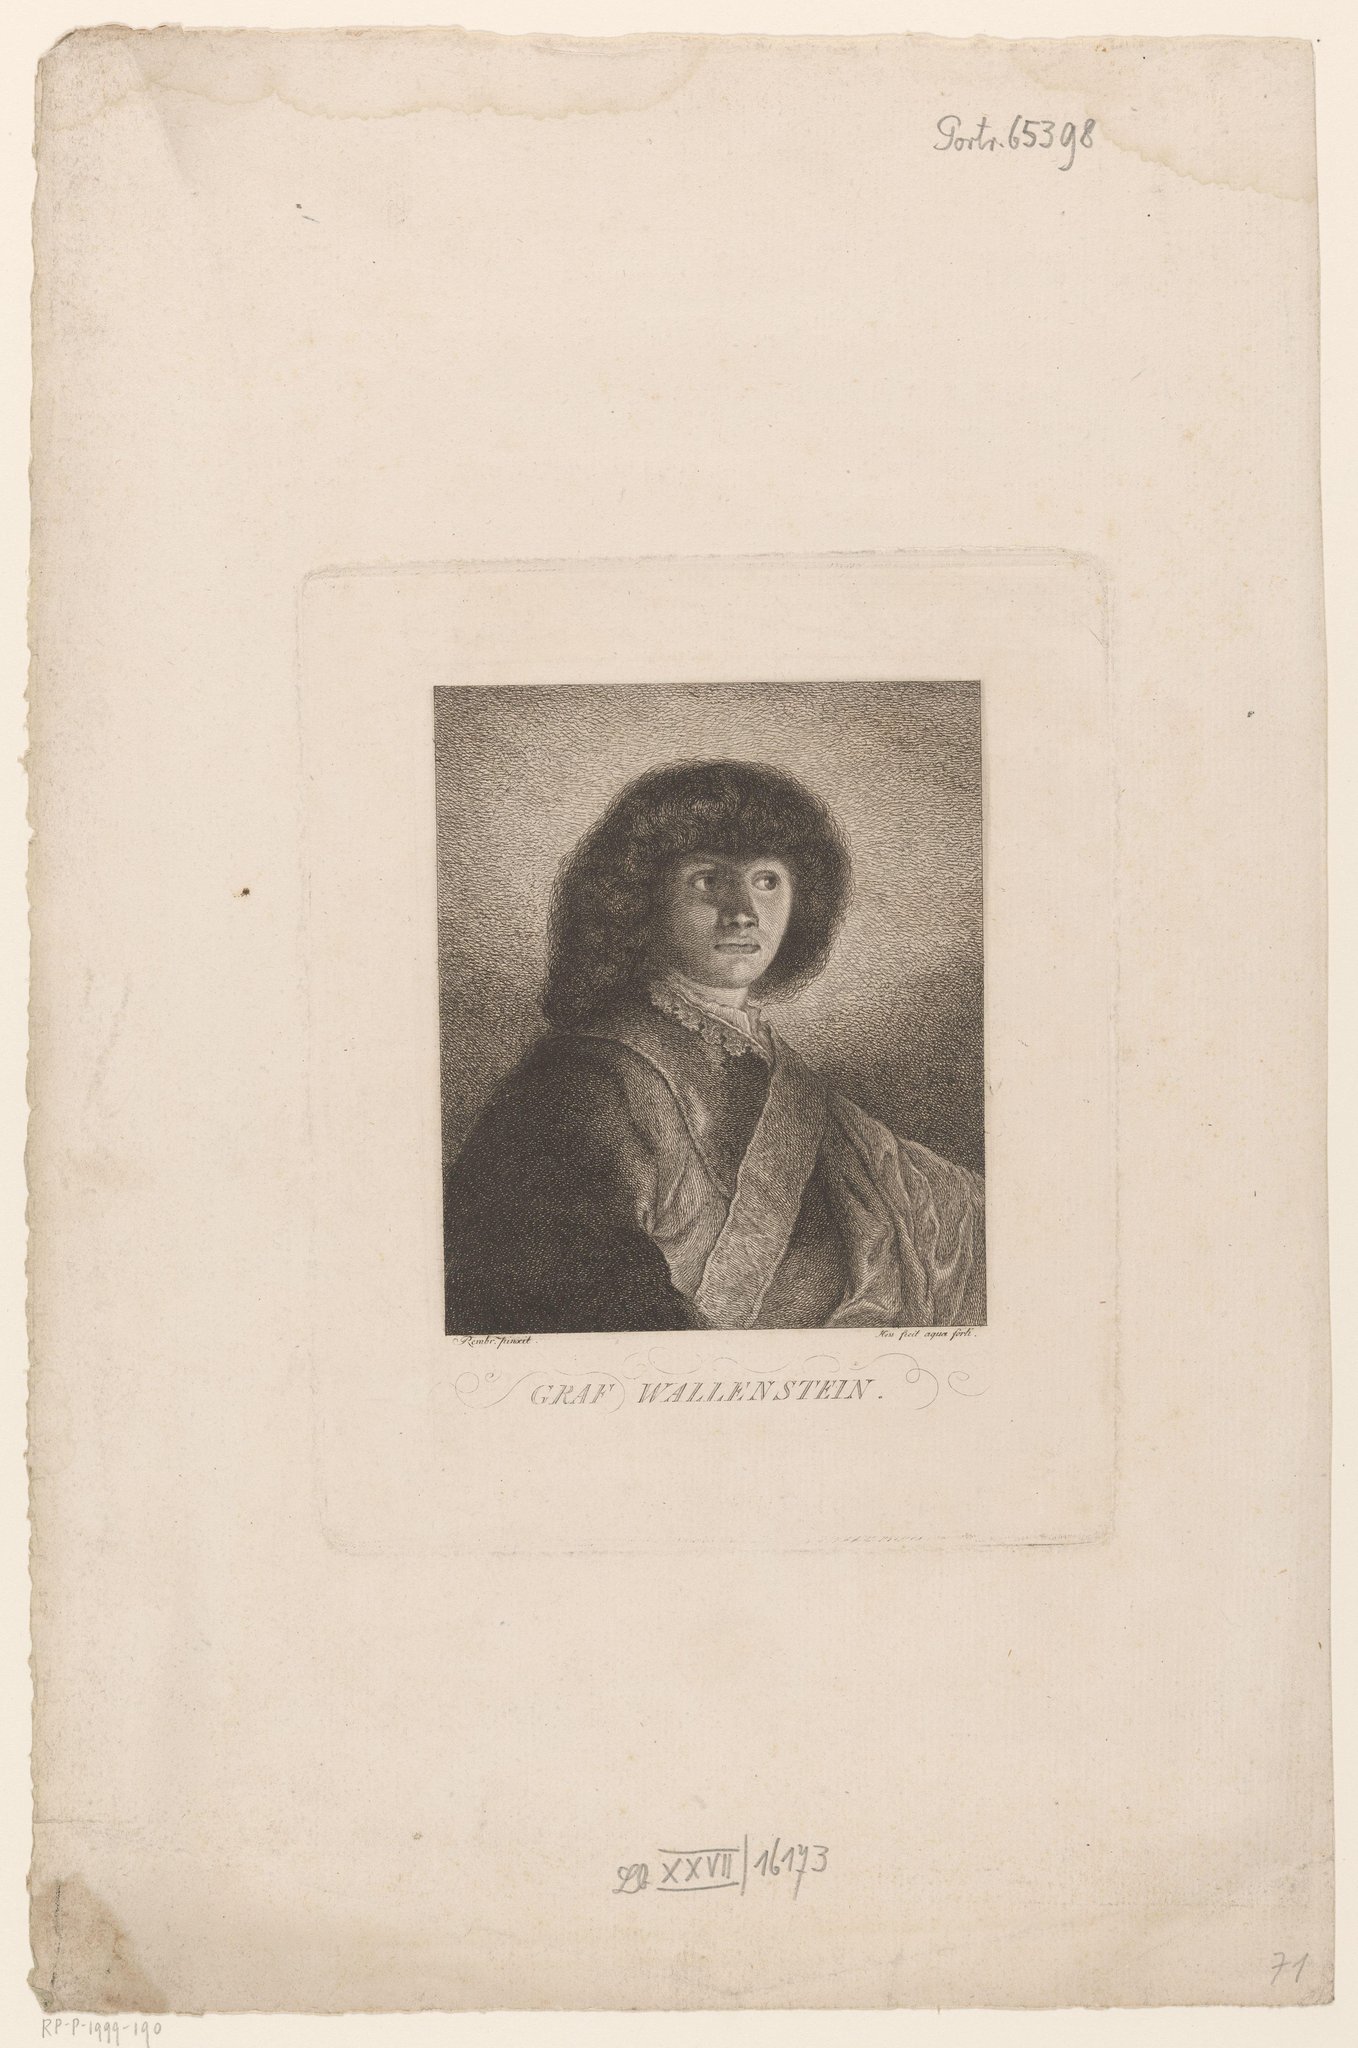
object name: print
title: Portret van Maximilian, Graf von Waldstein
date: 1765-1828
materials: paper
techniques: etching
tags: historical persons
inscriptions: collector's mark: Lugt 2760, collector's mark: Lugt 2228